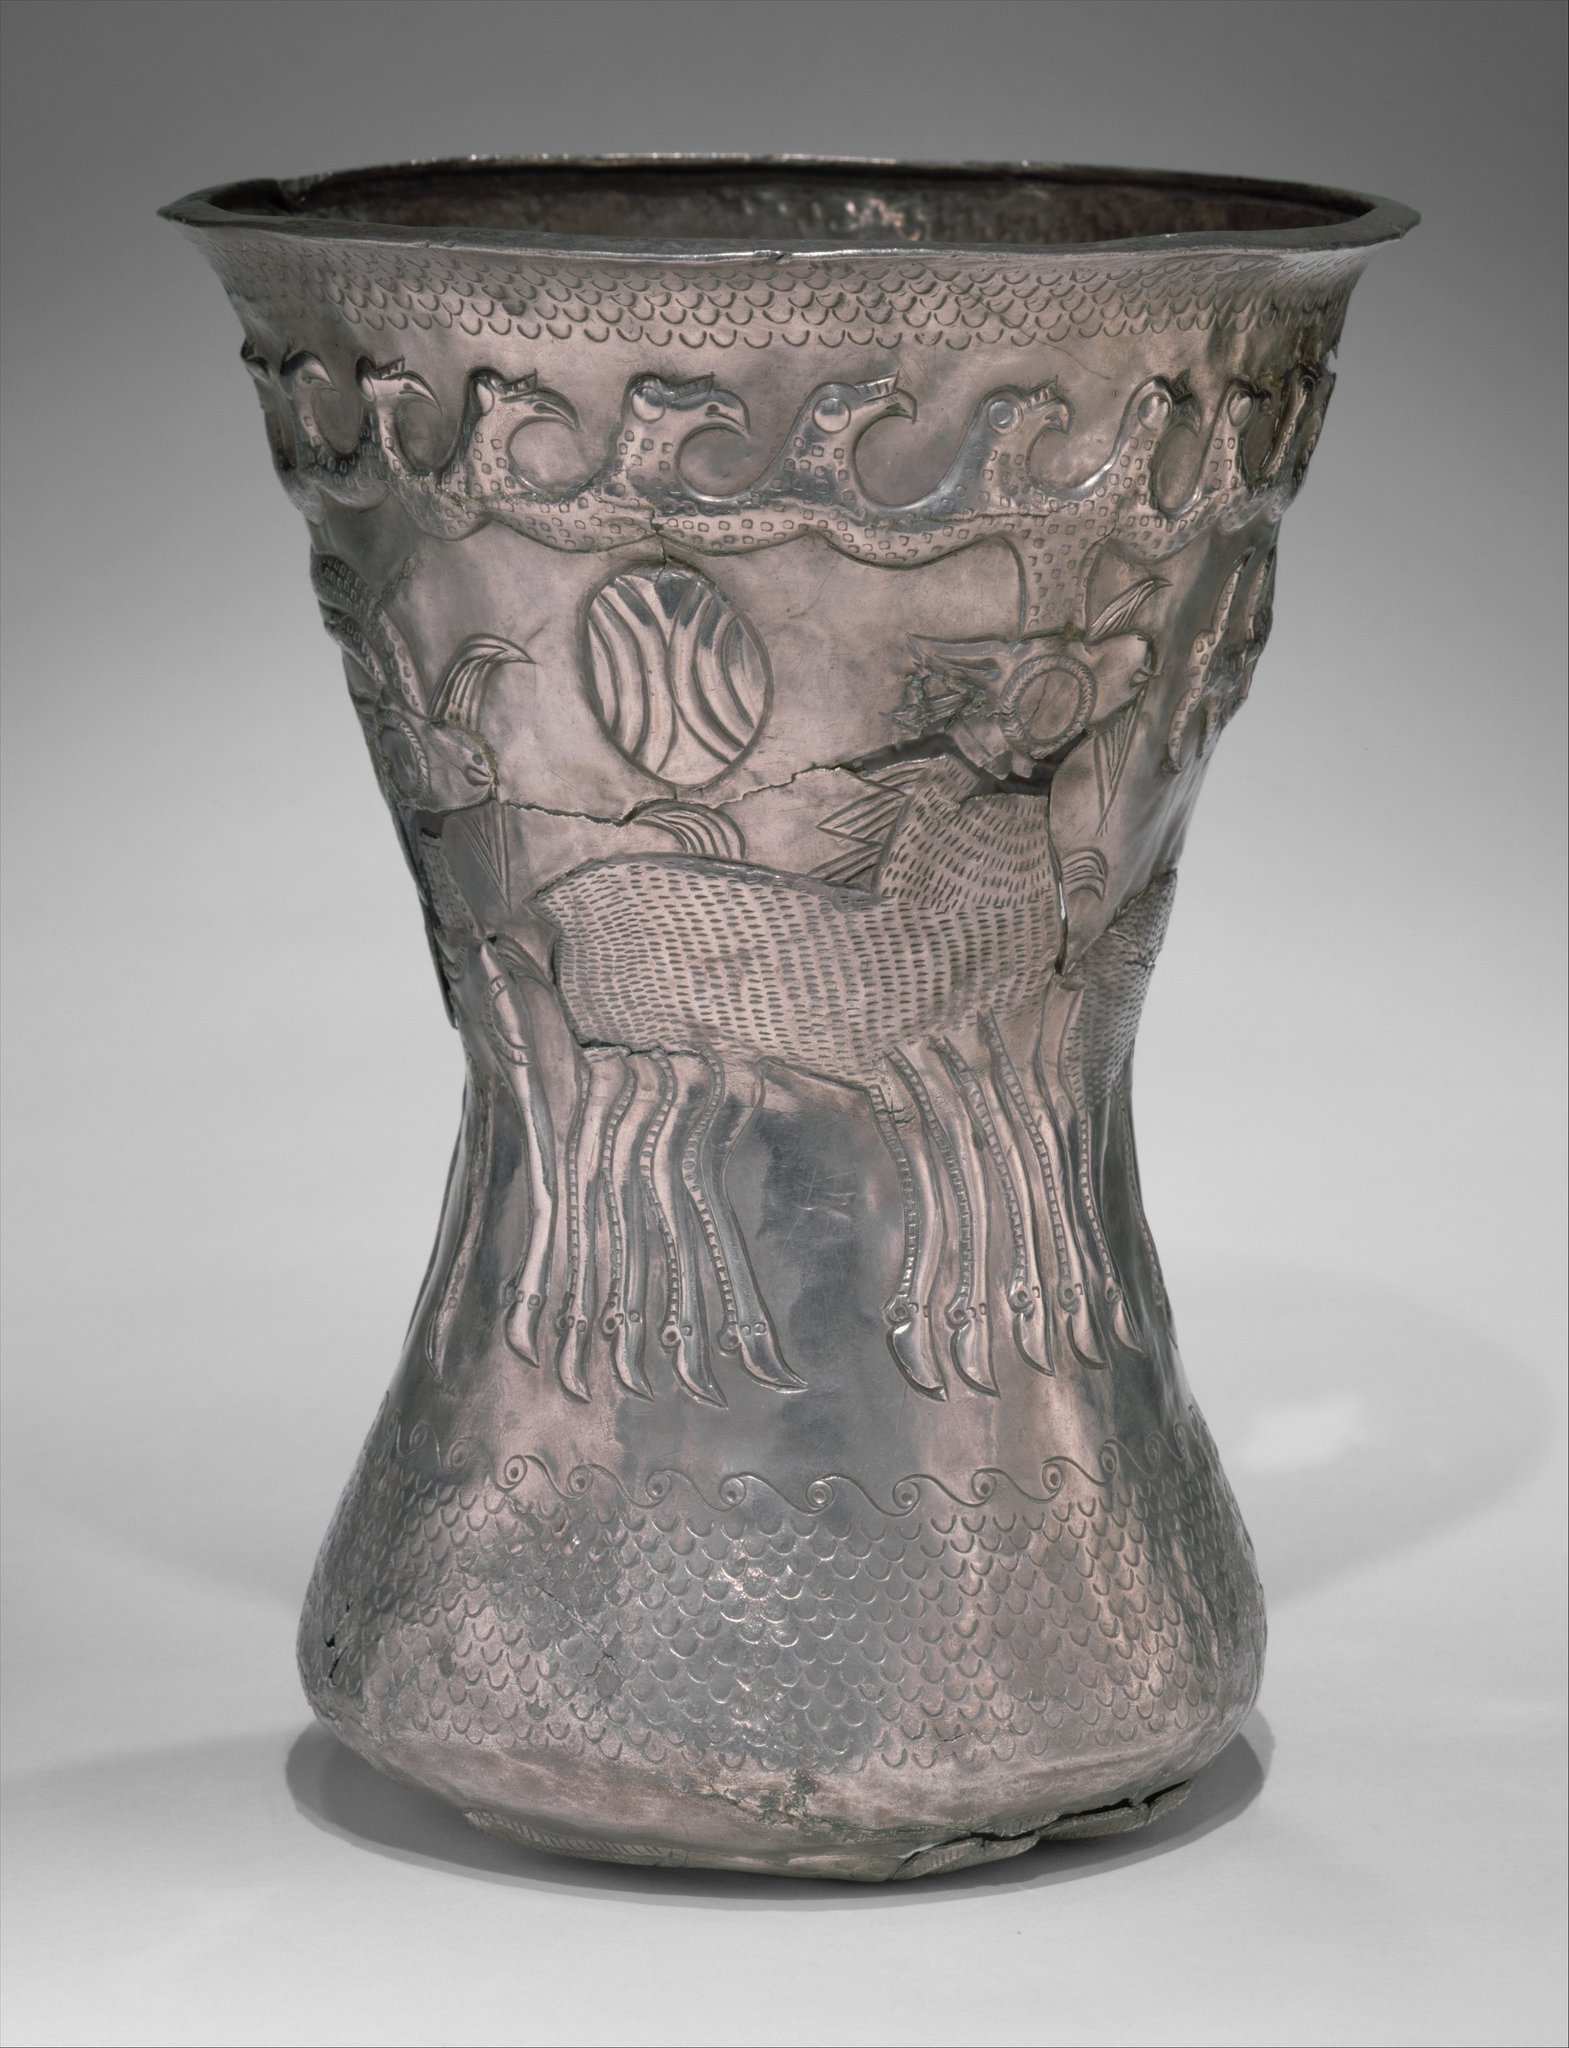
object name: beaker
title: Beaker with birds and animals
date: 400-301 BCE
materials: silver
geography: thrace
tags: birds,deer